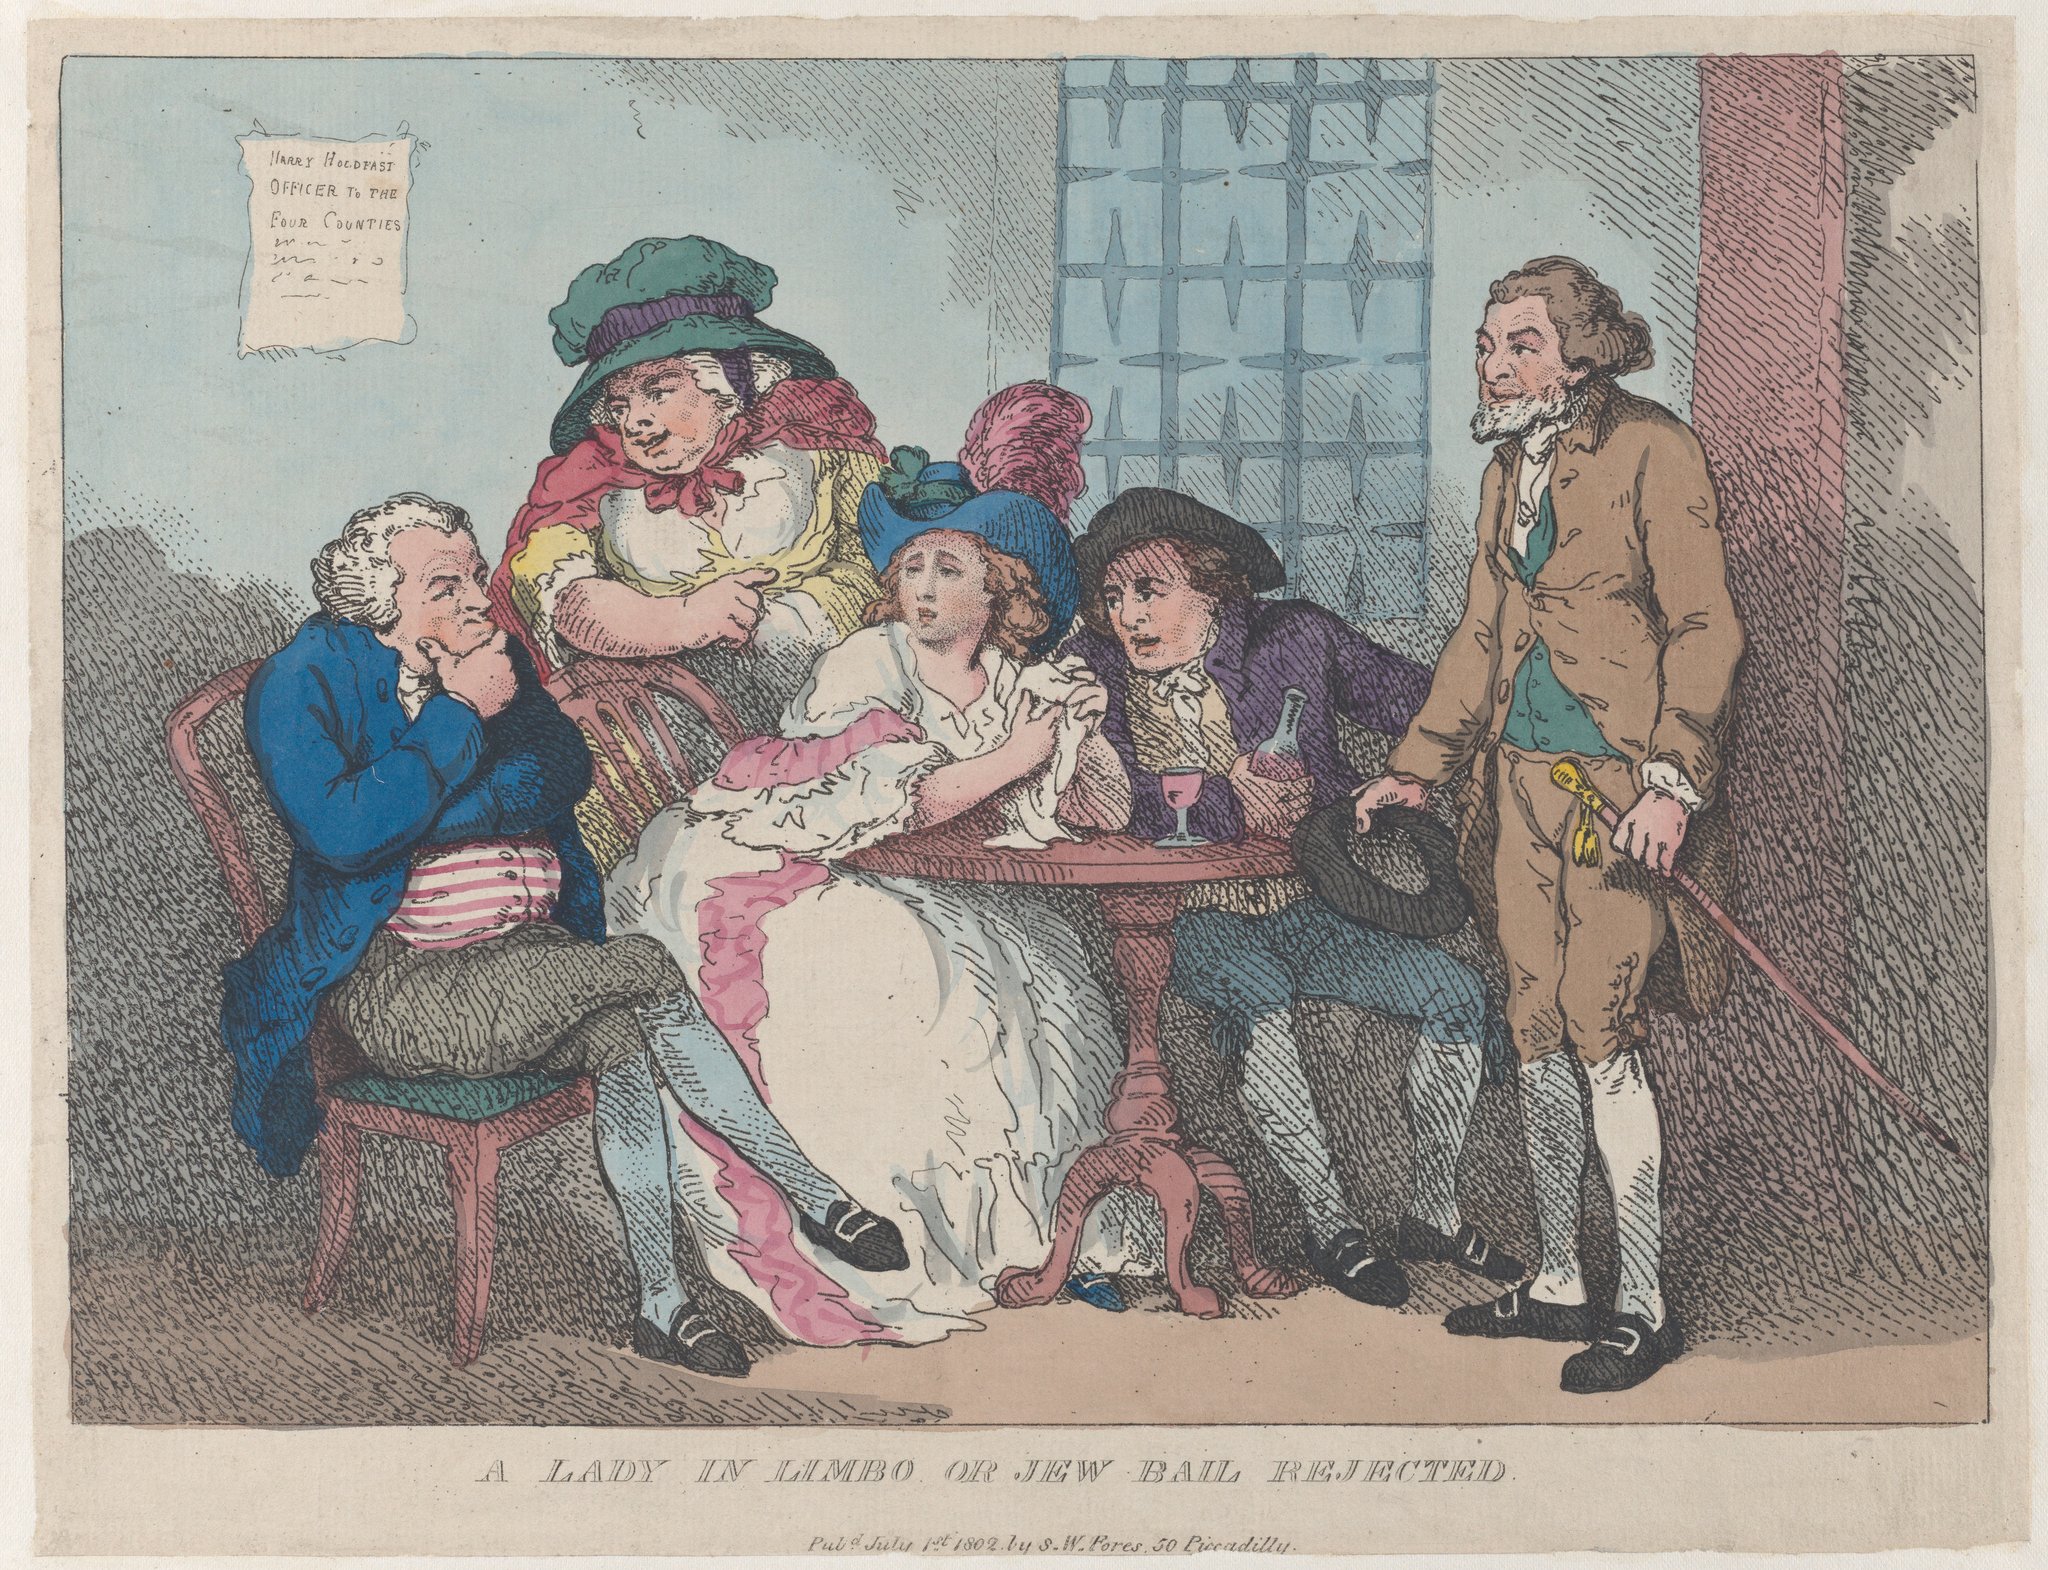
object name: print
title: A Lady in Limbo, or Jew Bail Rejected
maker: thomas rowlandson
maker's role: artist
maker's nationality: british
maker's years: 1757-1827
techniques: etching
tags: satire,men,women